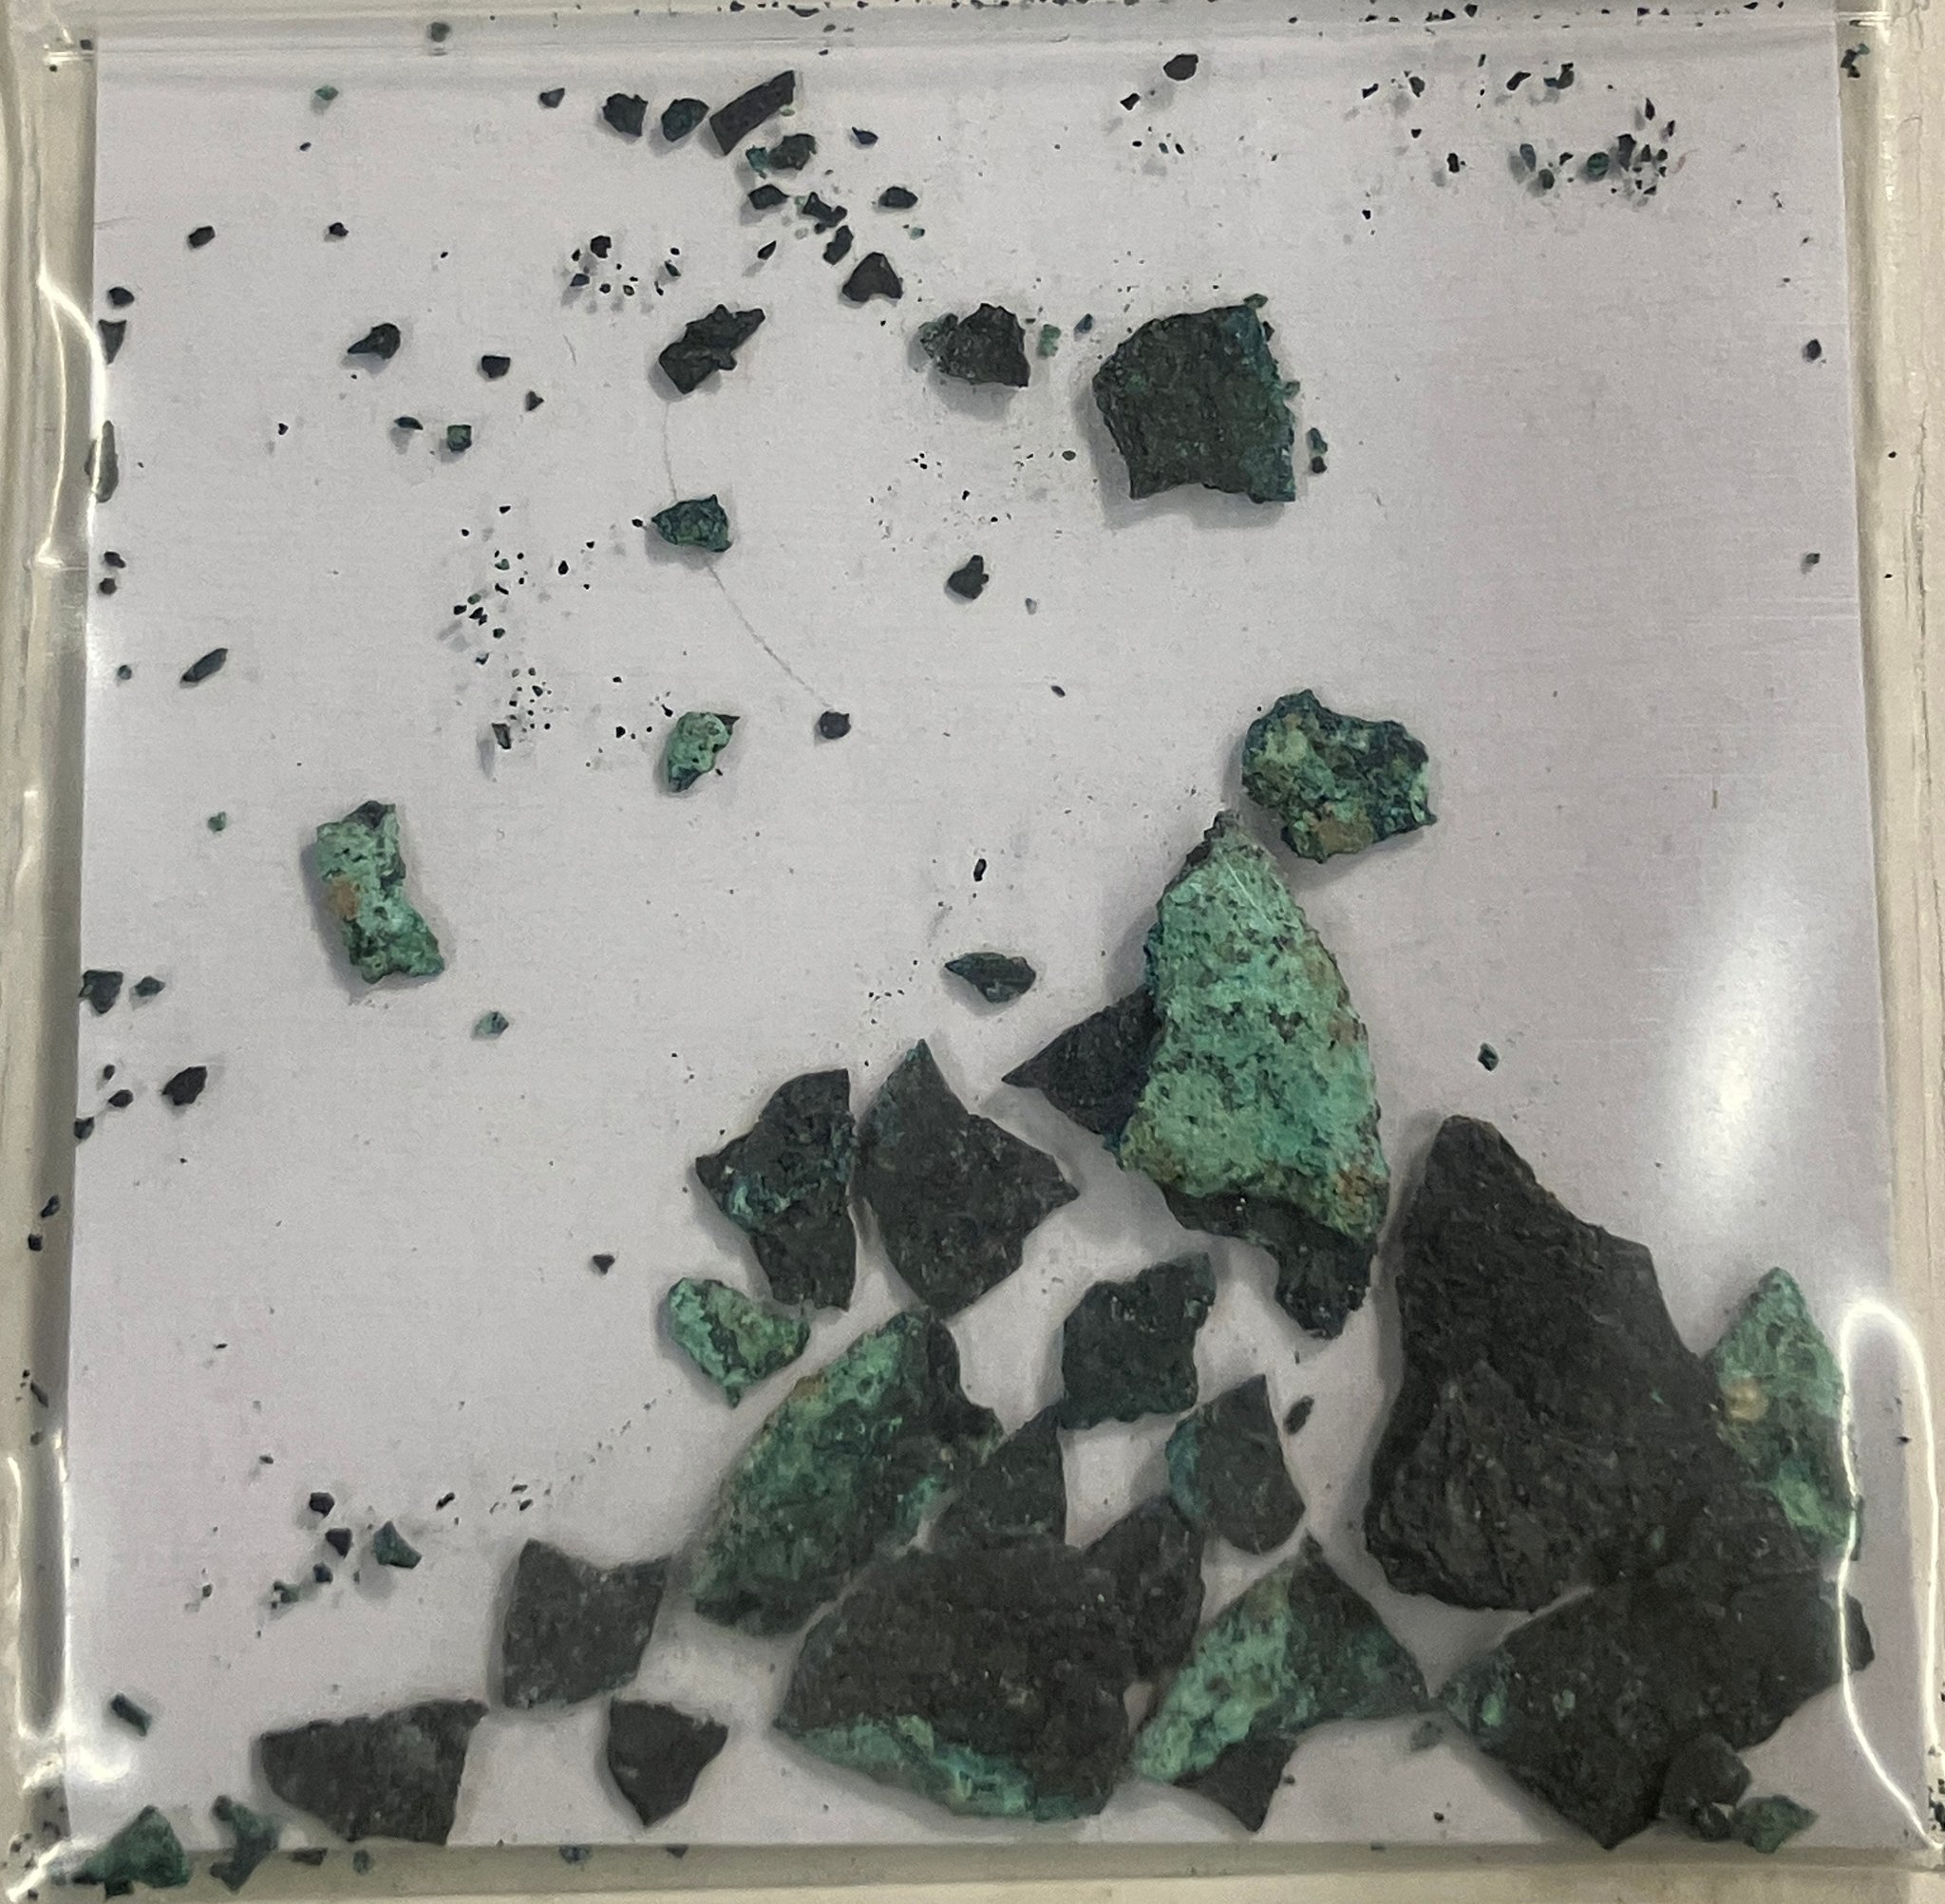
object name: coin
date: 801-1100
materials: silver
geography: iran